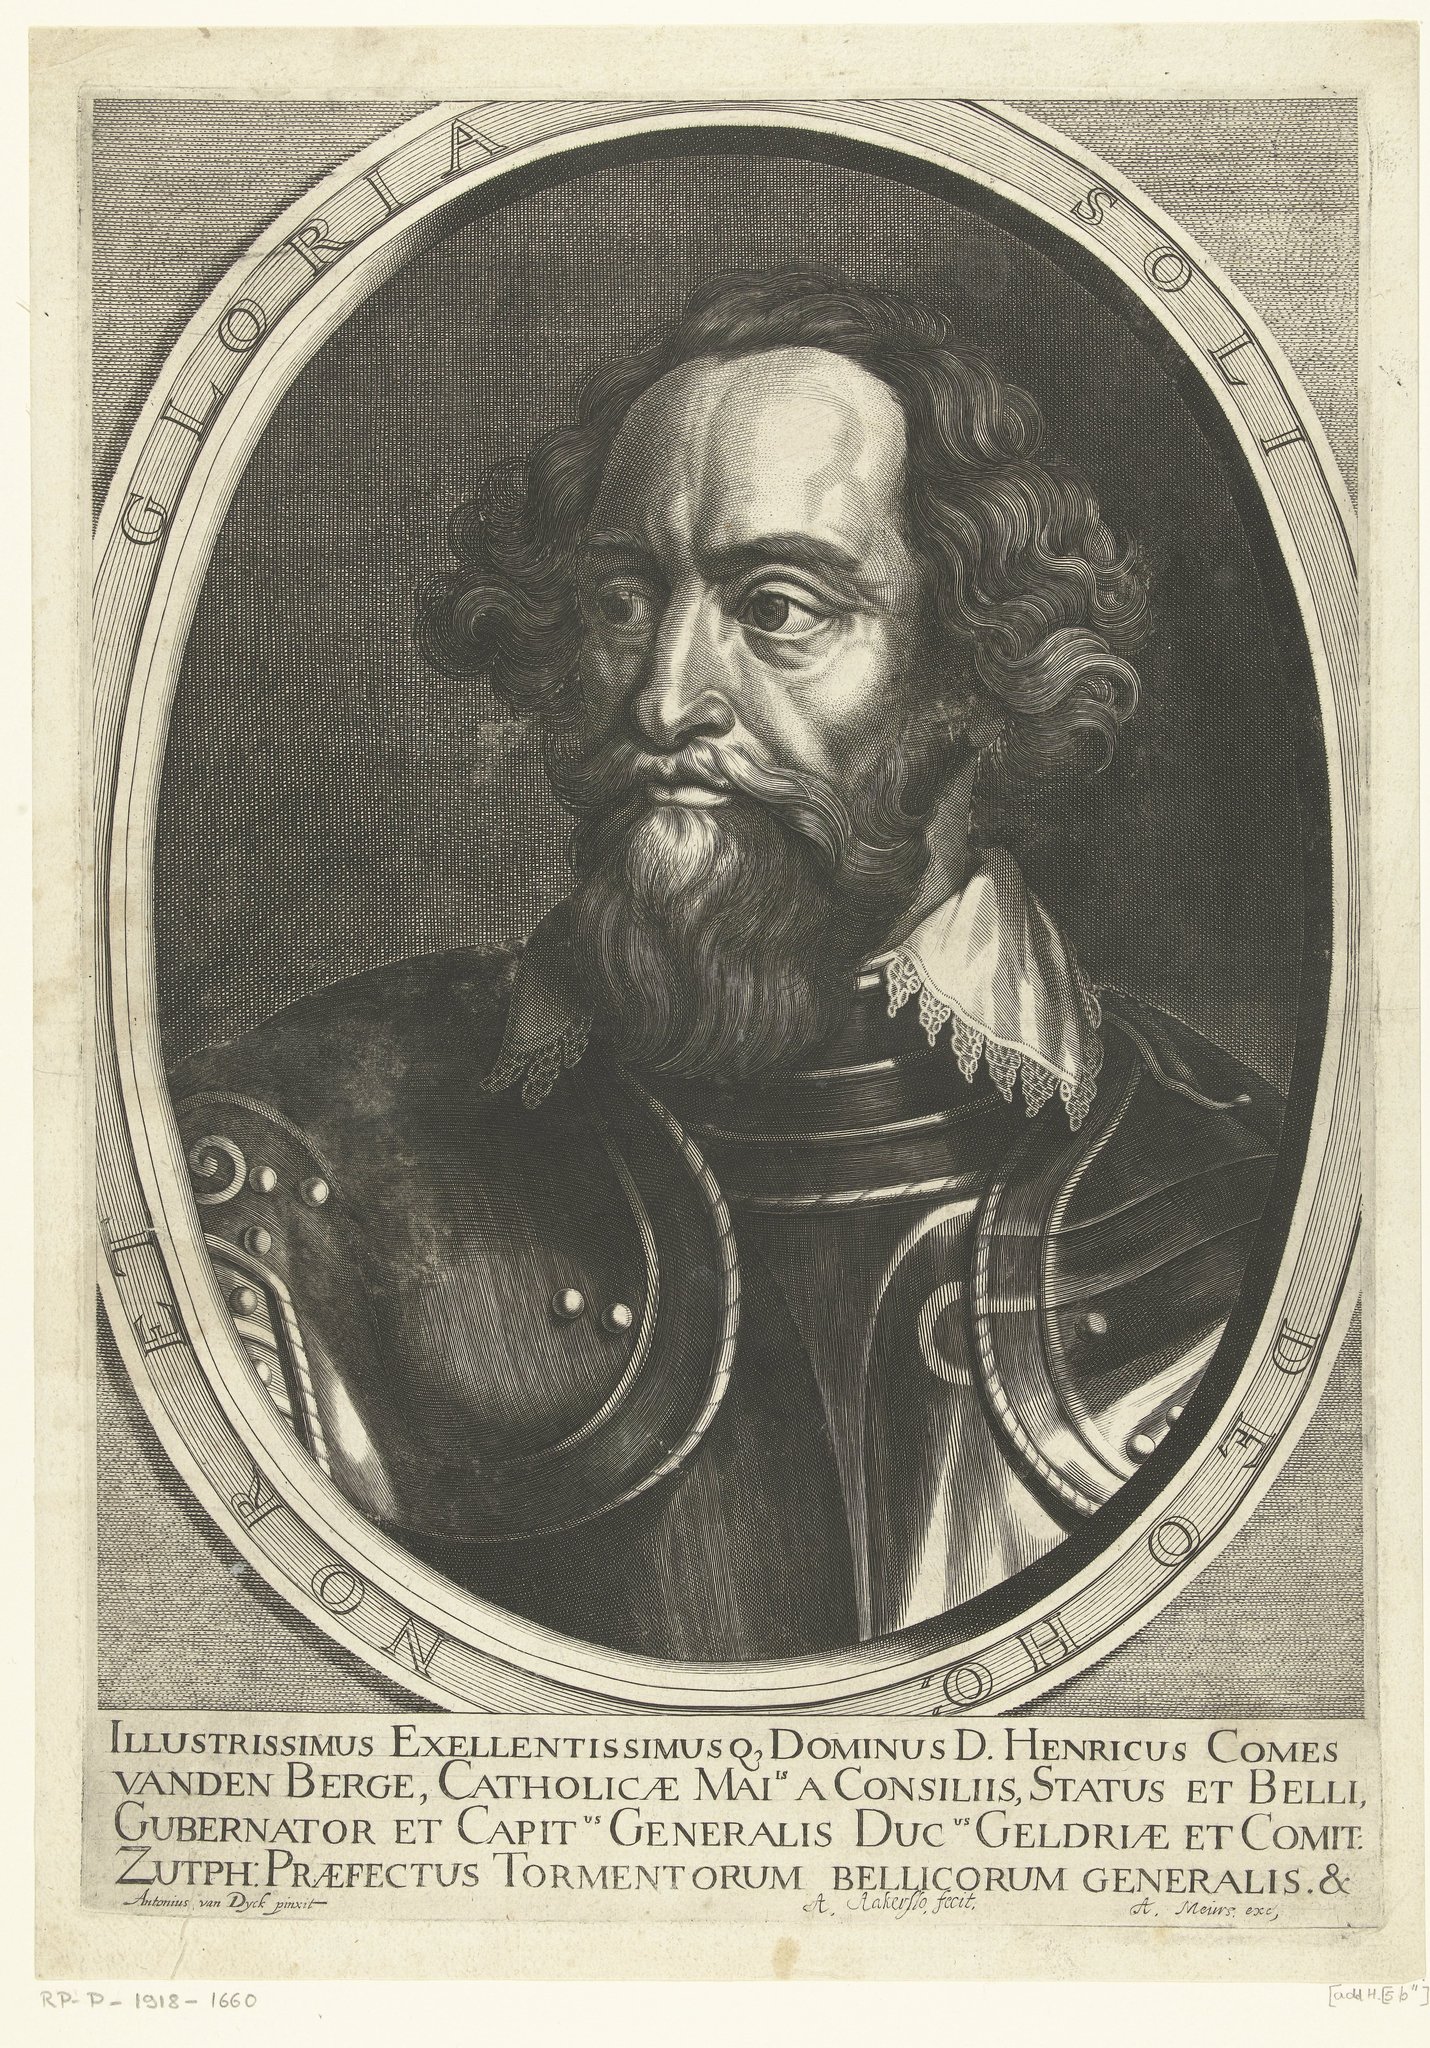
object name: print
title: Portret van Hendrik graaf van den Bergh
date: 1609-1642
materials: paper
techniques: engraving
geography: the hague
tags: earl, historical persons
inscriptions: collector's mark: Lugt 2228, collector's mark: Lugt 2233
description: Portretbuste met het hoofd naar links, blootshoofds, in een harnas, in een ovale lijst met randschrift: Soli Deo Honor Et Gloria. In de marge een Latijns onderschrift van vier regels: Illustrissimus Excellentissimusq., Dominus D. Henricus Comes vanden Berge [...].